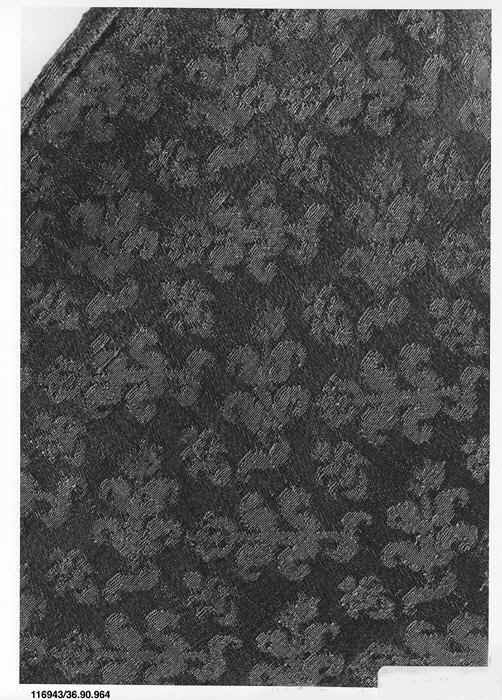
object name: piece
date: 1601-1700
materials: silk